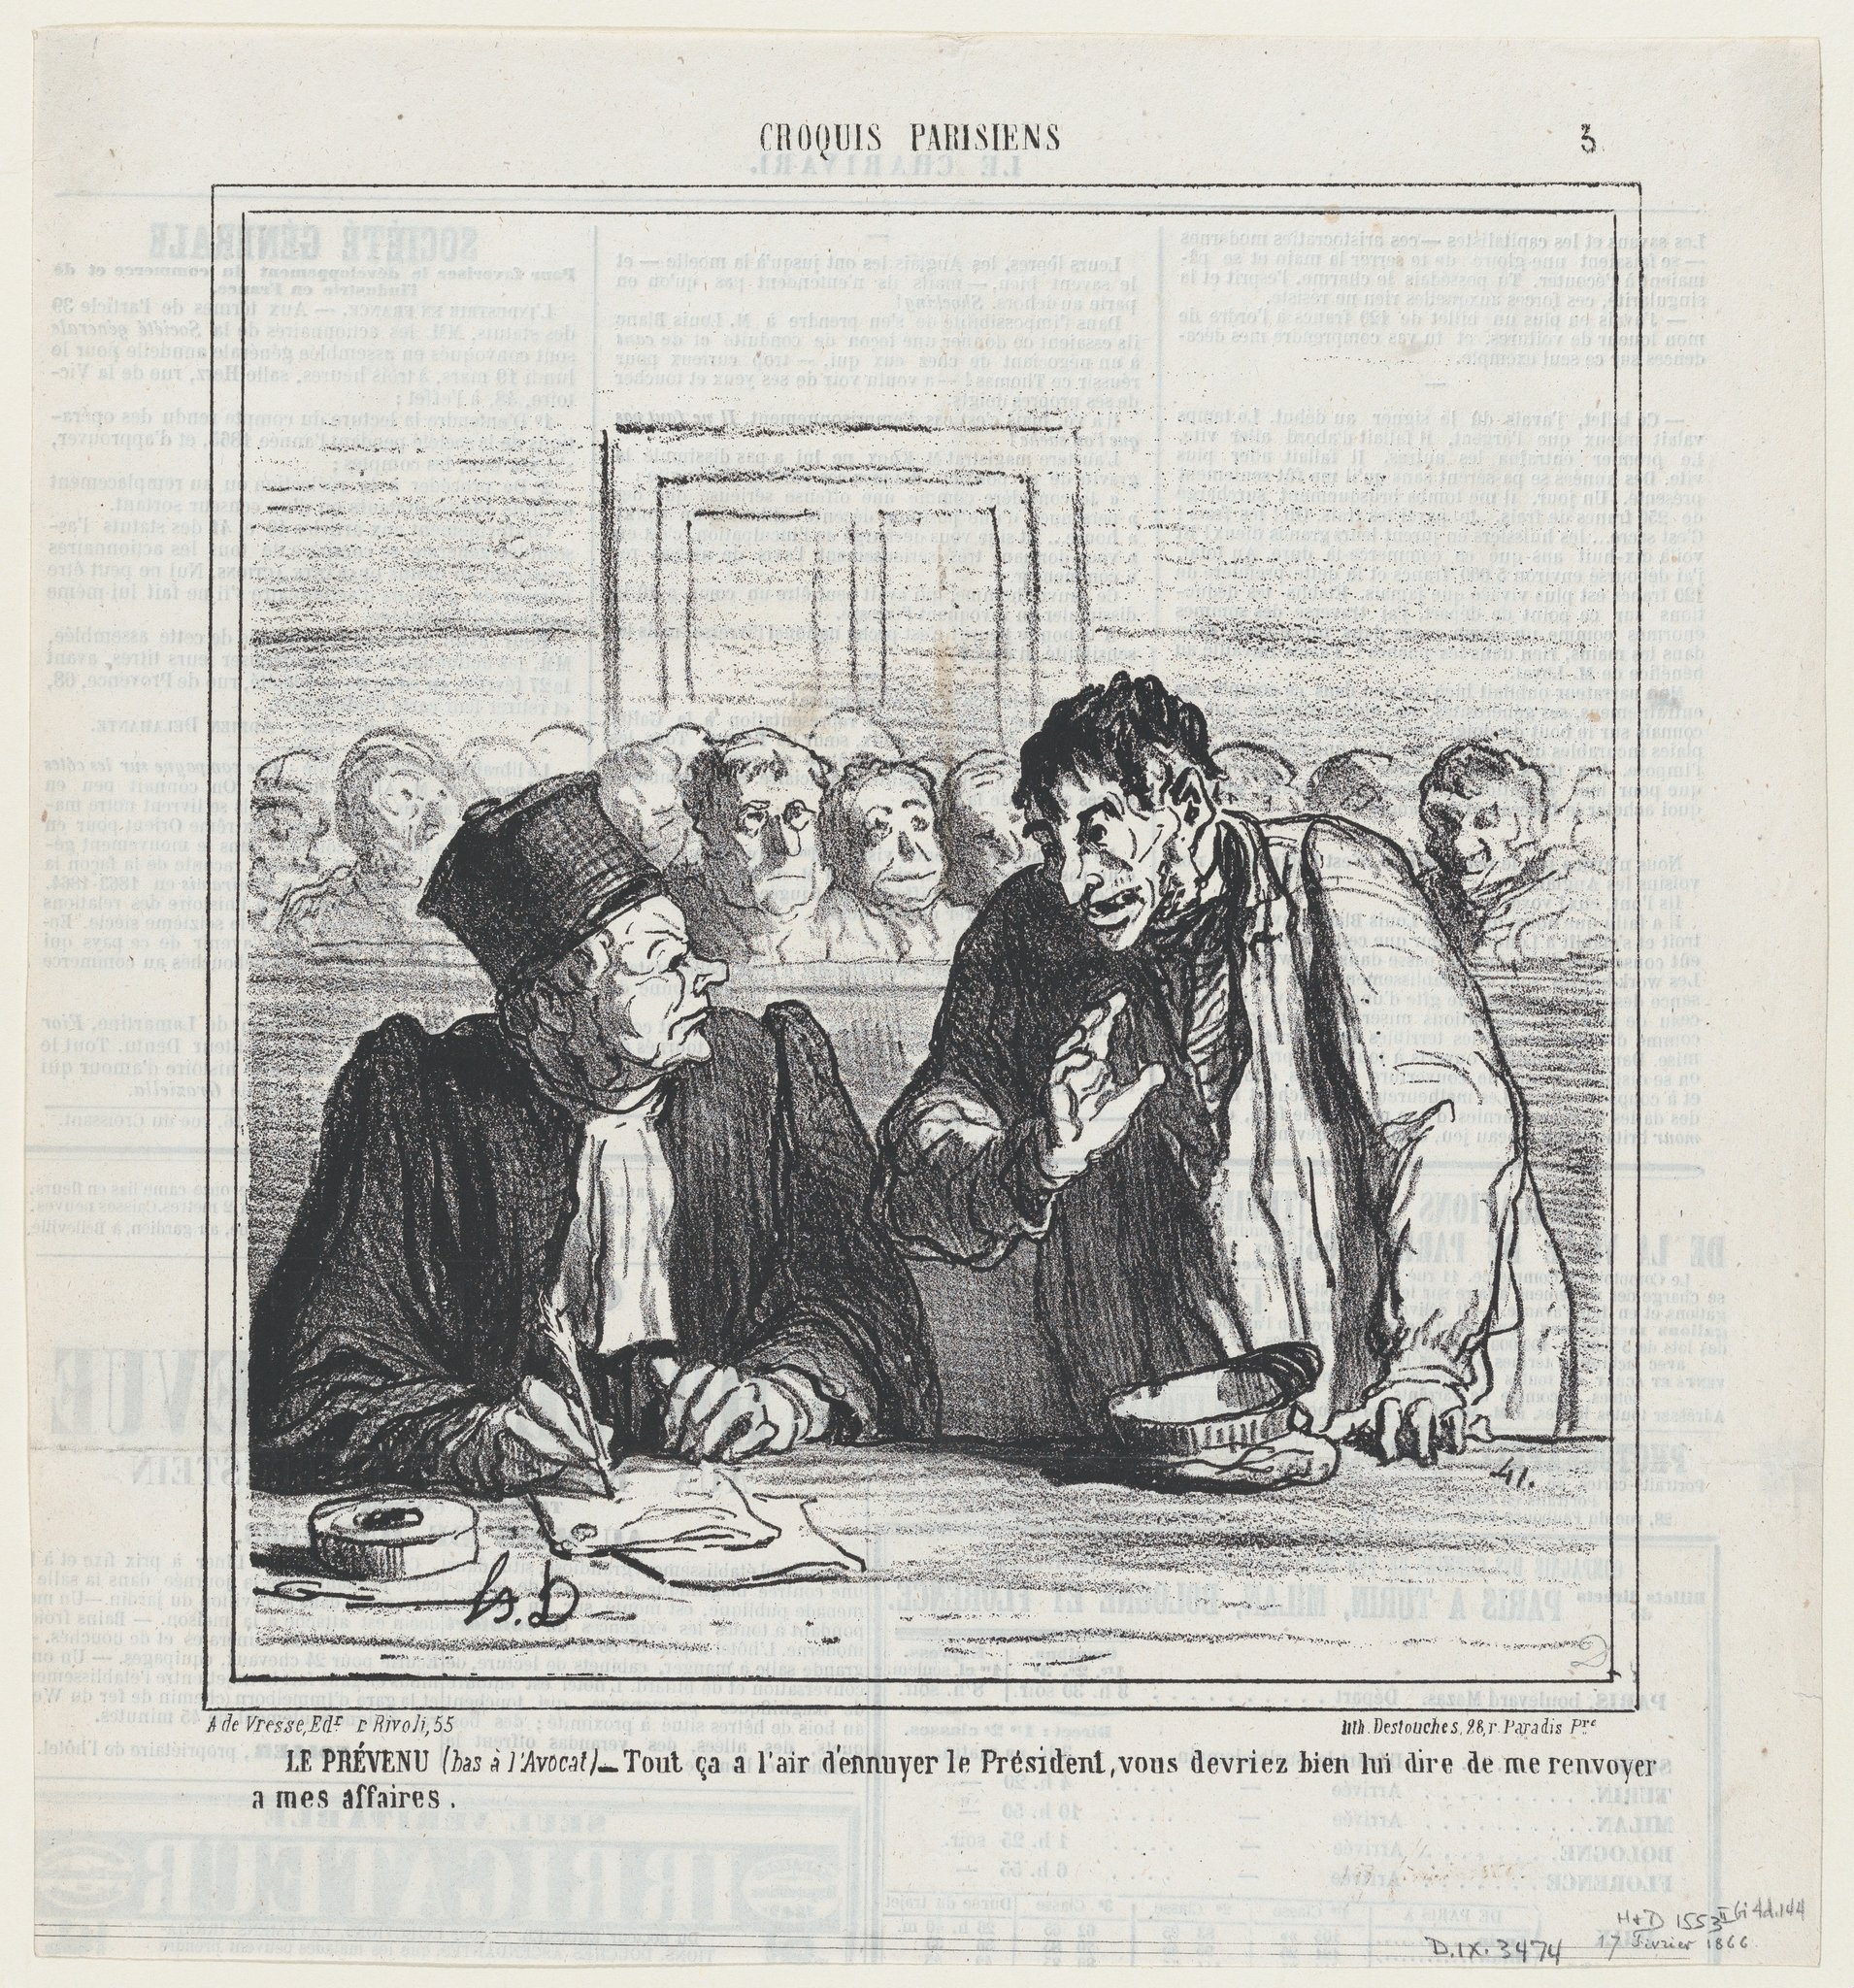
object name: print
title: The defendant (whispering to his lawyer): All this seems to bore the president. Why don't you just suggest to simply let me go home, from 'Parisian sketches,' published in Le Charivari, February 17, 1866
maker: honoré daumier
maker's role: artist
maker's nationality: french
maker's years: 1808-1879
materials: paper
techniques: lithograph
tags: satire,men,writing